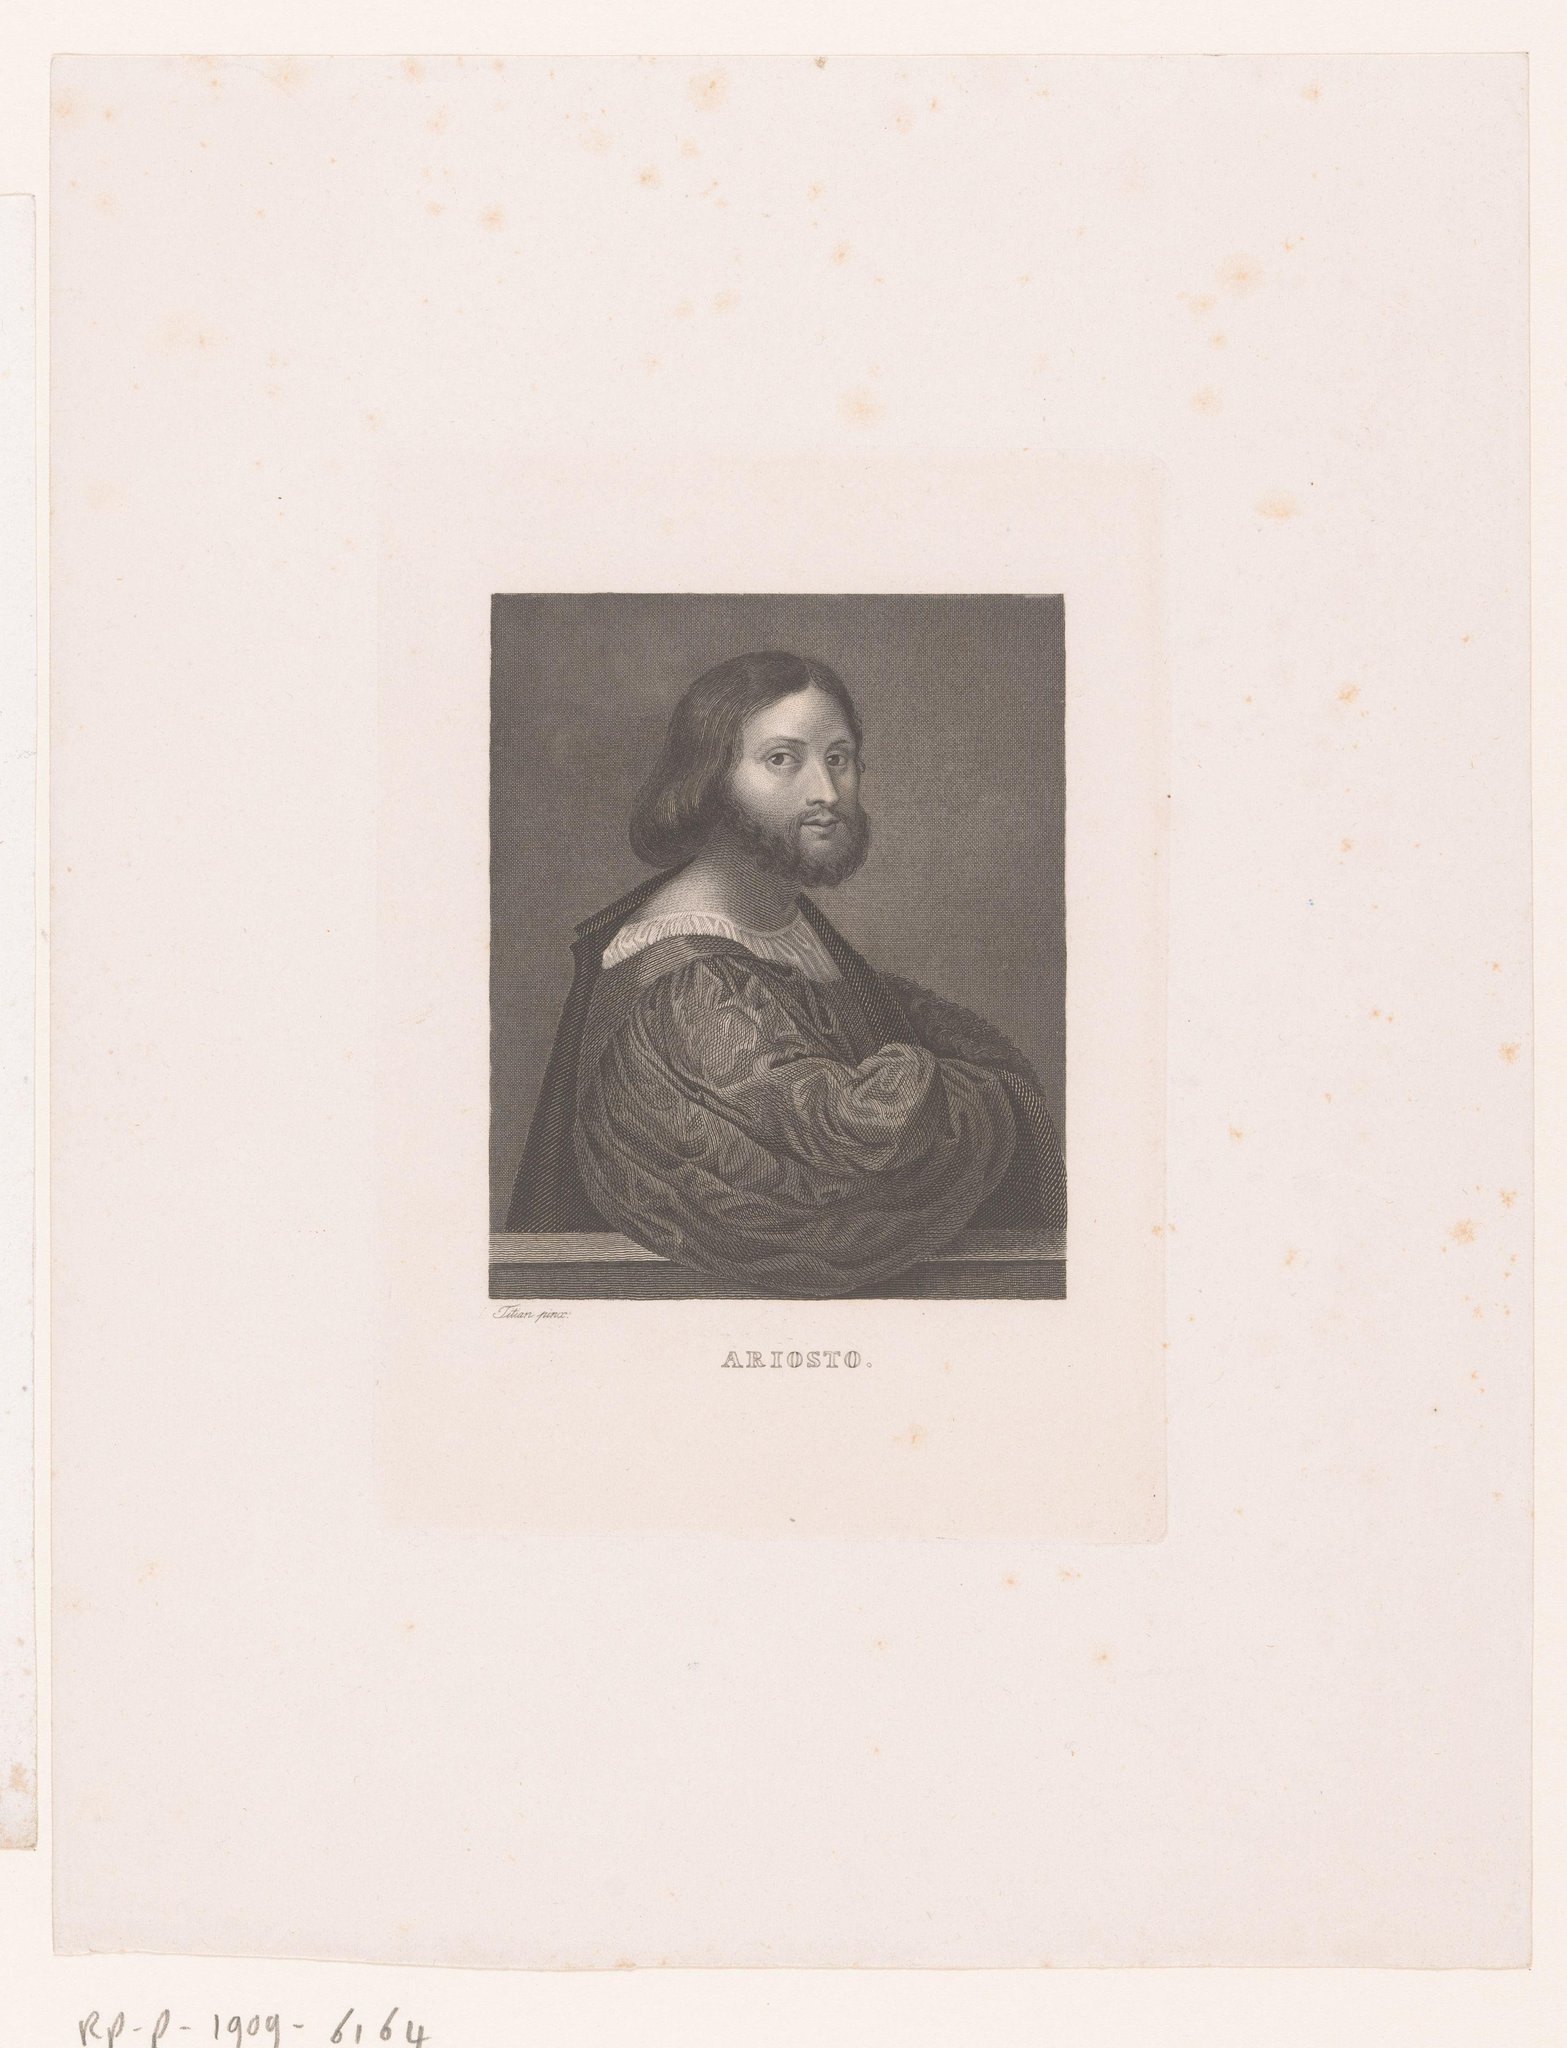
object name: print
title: Portret van Ludovico Ariosto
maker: Anonymous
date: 1850-1899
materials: paper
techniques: engraving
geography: germany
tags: ludovico ariosto, historical persons, writer, poet, author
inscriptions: collector's mark: Lugt 2228